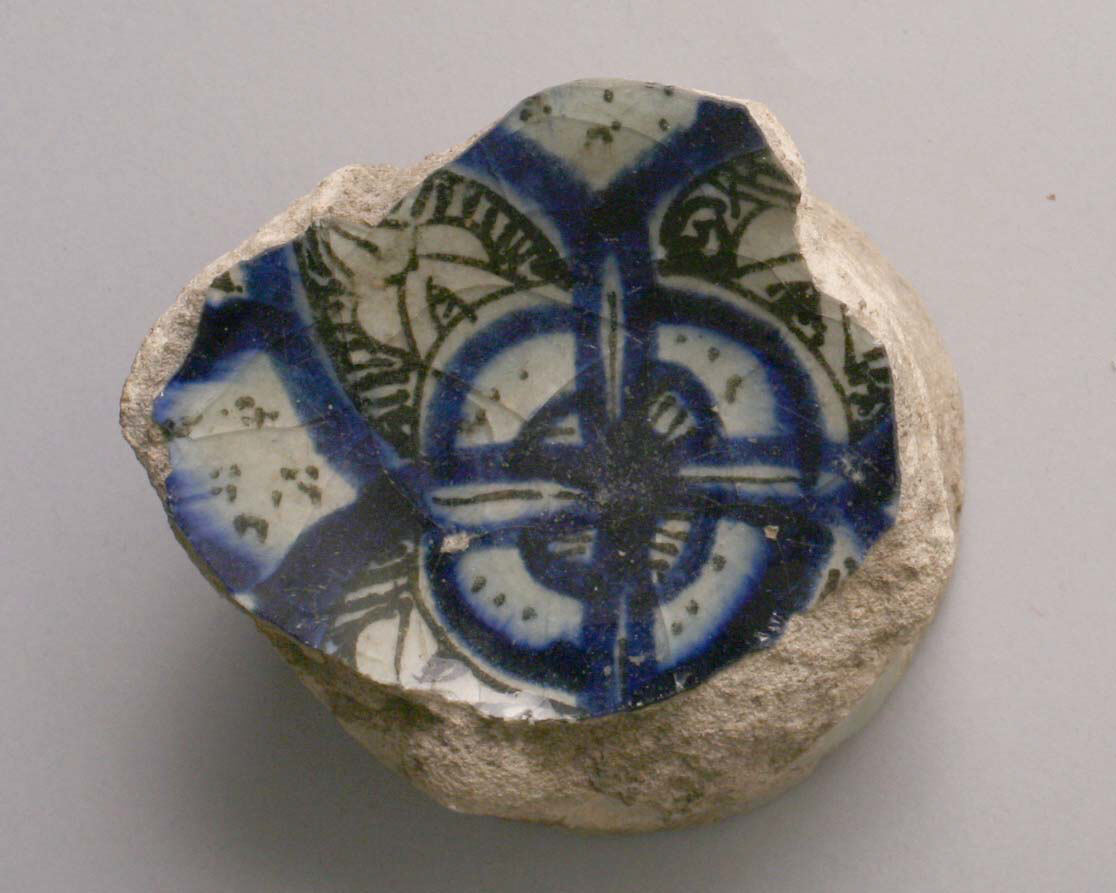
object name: ceramic fragment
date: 1301-1400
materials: glaze, stonepaste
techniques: painting, polychrome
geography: syria